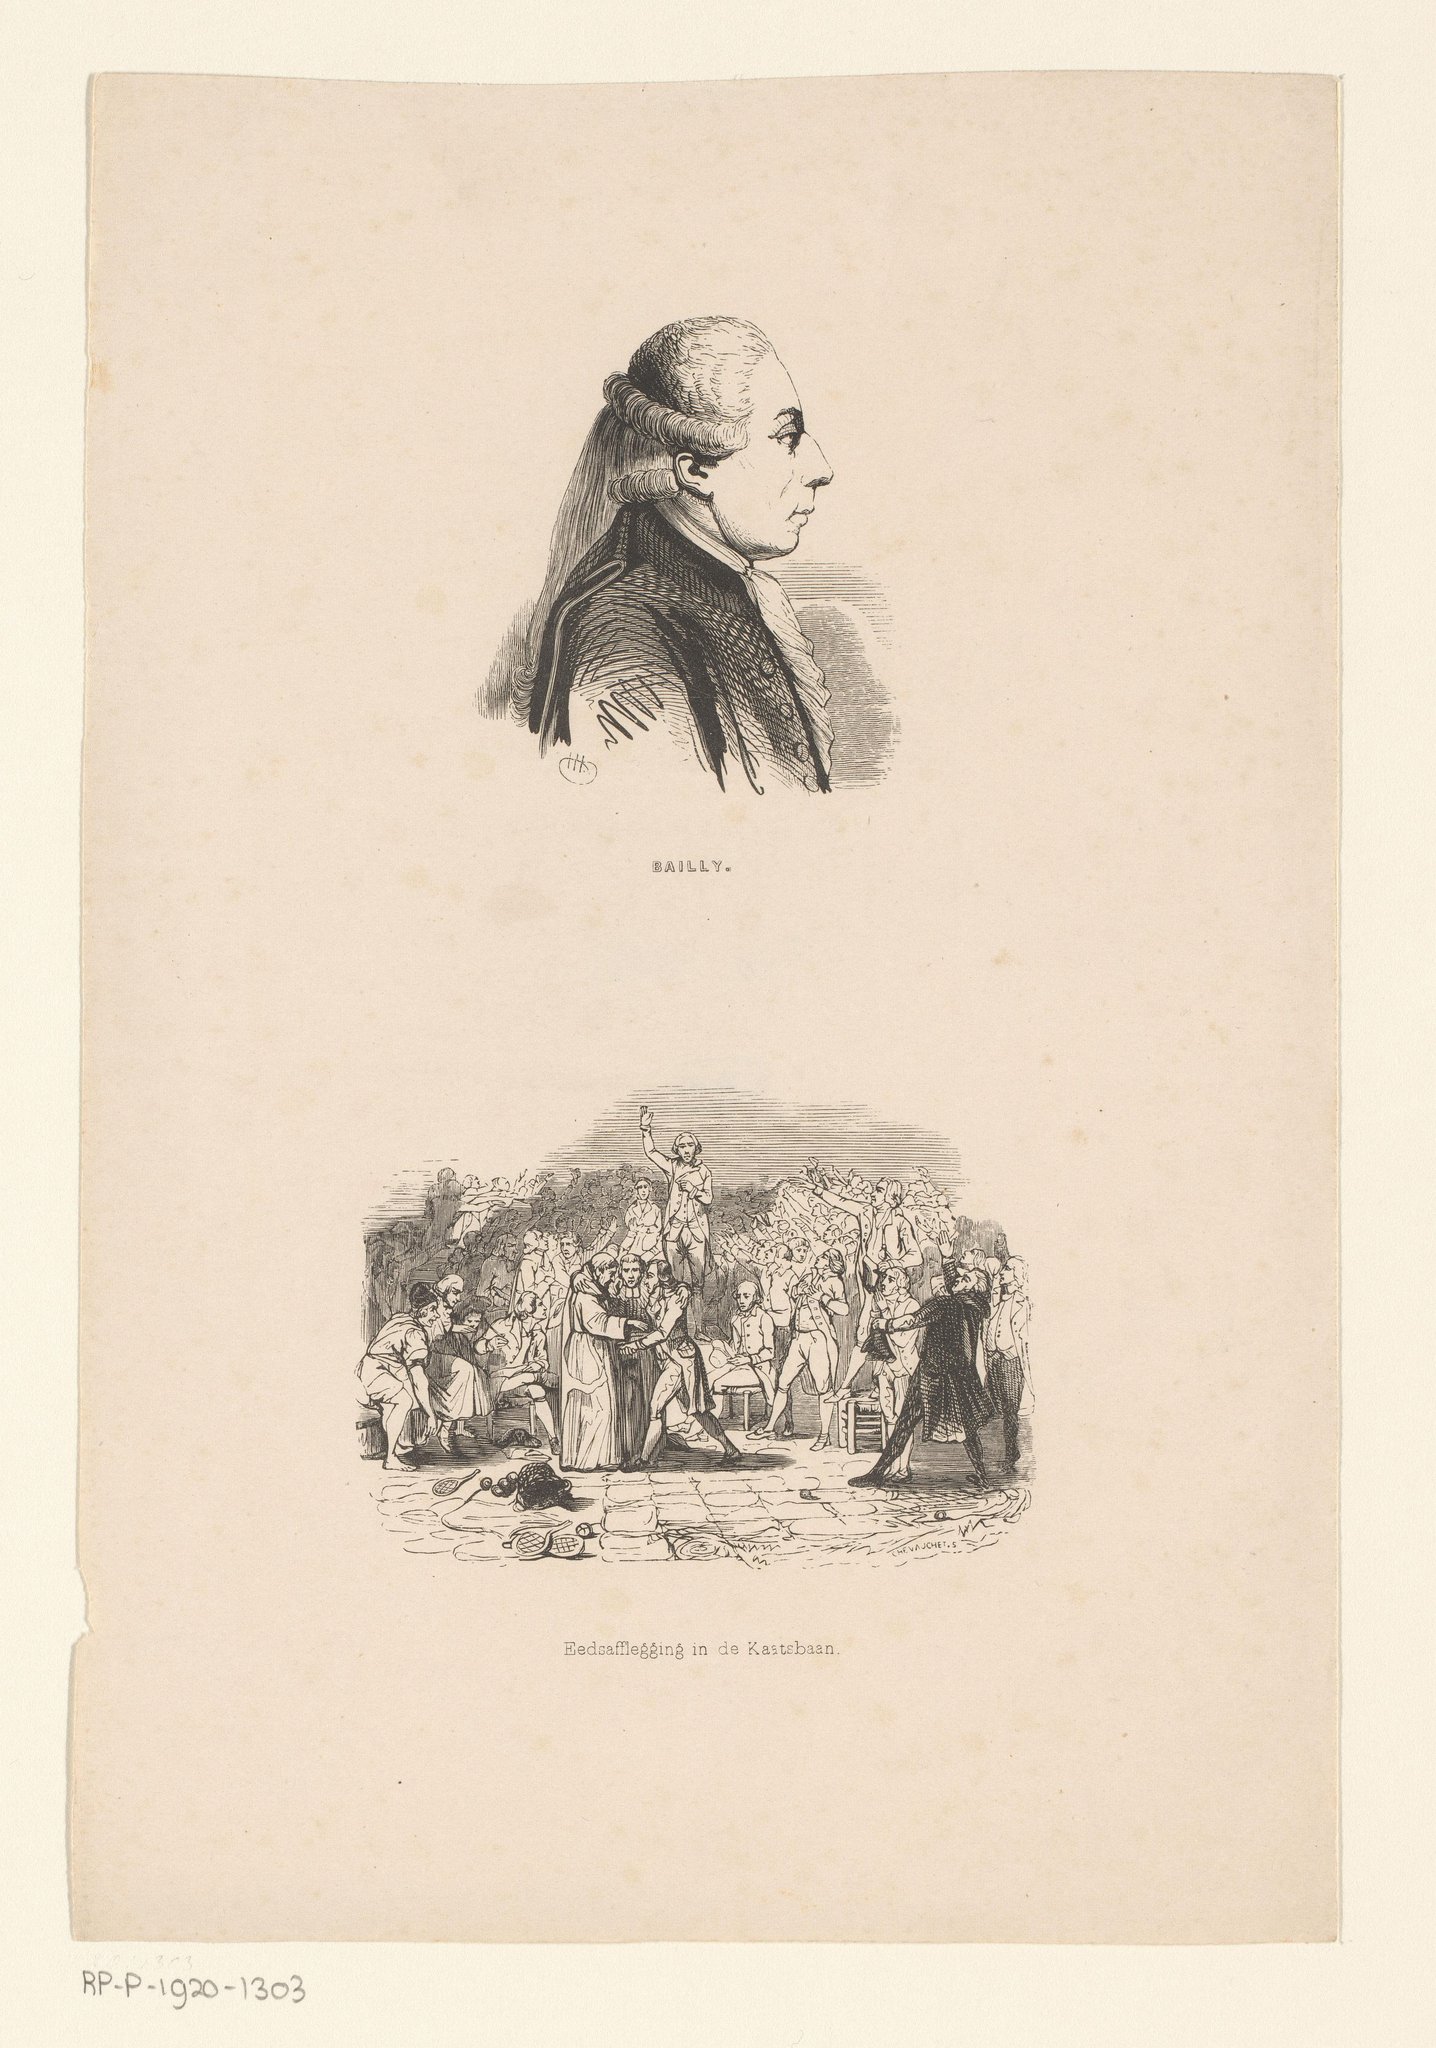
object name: print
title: Bailly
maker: chevachet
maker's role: print maker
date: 1800-1900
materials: paper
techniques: engraving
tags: paris, politician, mayor, burgomaster, historical persons, swearing an oath (with two fingers raised), ball games in which ball is hit with racket (or hand)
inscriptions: collector's mark: Lugt 2228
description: Blad met twee afzonderlijke voorstellingen.